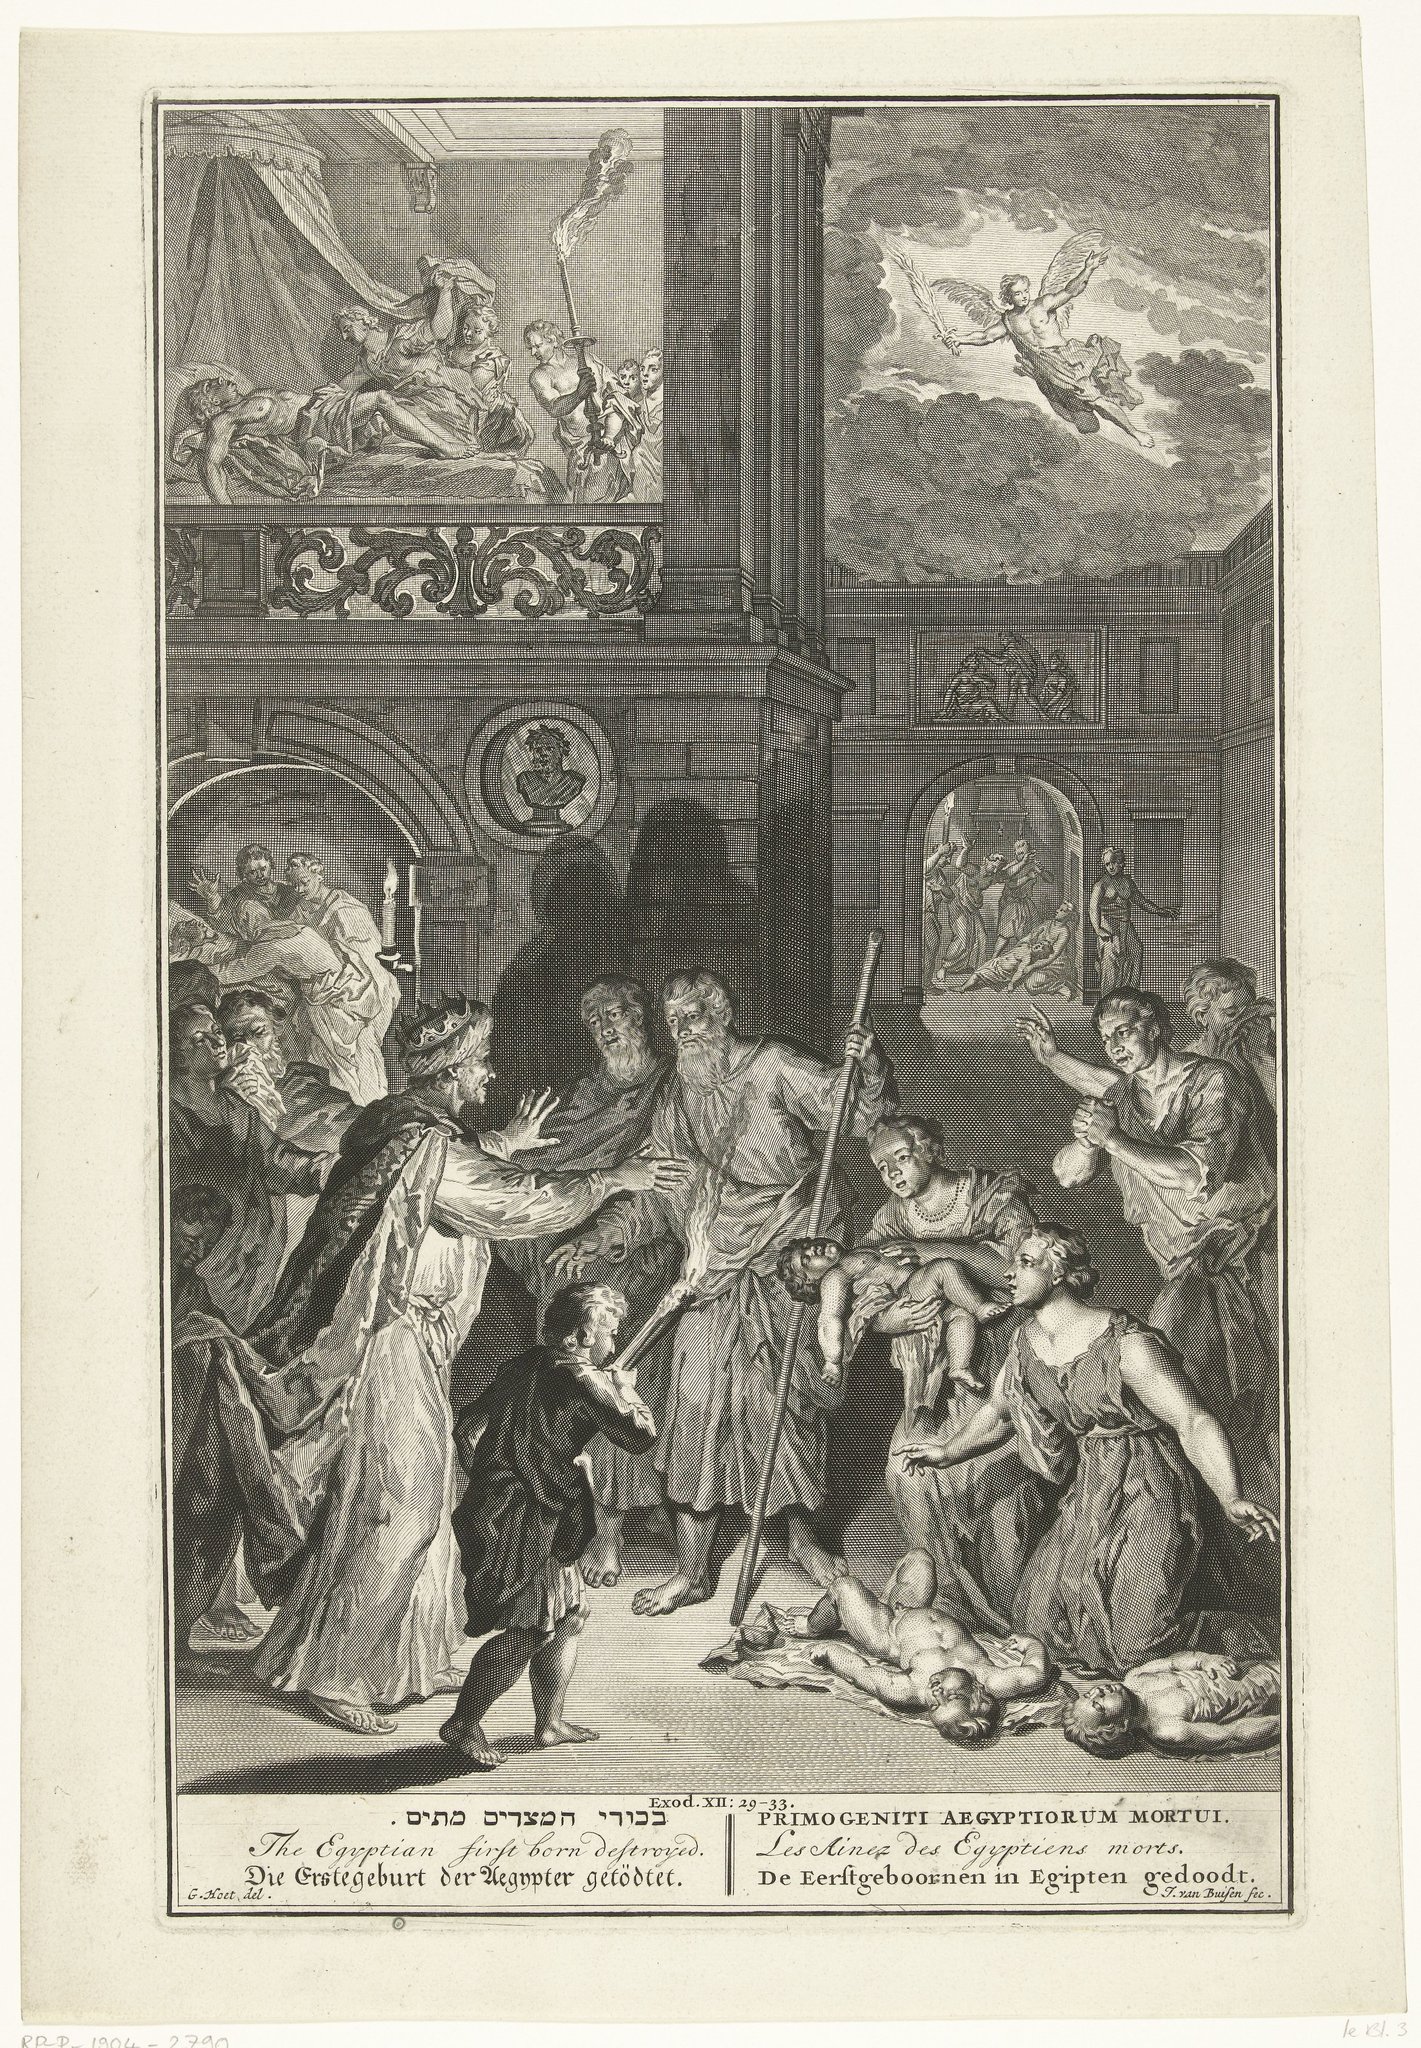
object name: print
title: Dood van de eerstgeborenen in Egypte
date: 1711-1720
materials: paper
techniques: engraving, etching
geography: amsterdam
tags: the plague of the first-born: the destroying angel passes through the land and kills every egyptian first-born of man and animal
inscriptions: collector's mark: Lugt 2228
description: God straft de Egyptenaren door al hun eerstgeborenen te doden. In elk huis is een dood kind te betreuren. Ook de zoon van de farao is gedood. Rechts boven de engel Gods die de dood over Egypte heeft gebracht. Illustratie voor het Oude Testament, Exod. 12:29-33. Onder de voorstelling een titel in het Hebreeuws, Engels, Duits, Latijn, Frans en Nederlands.